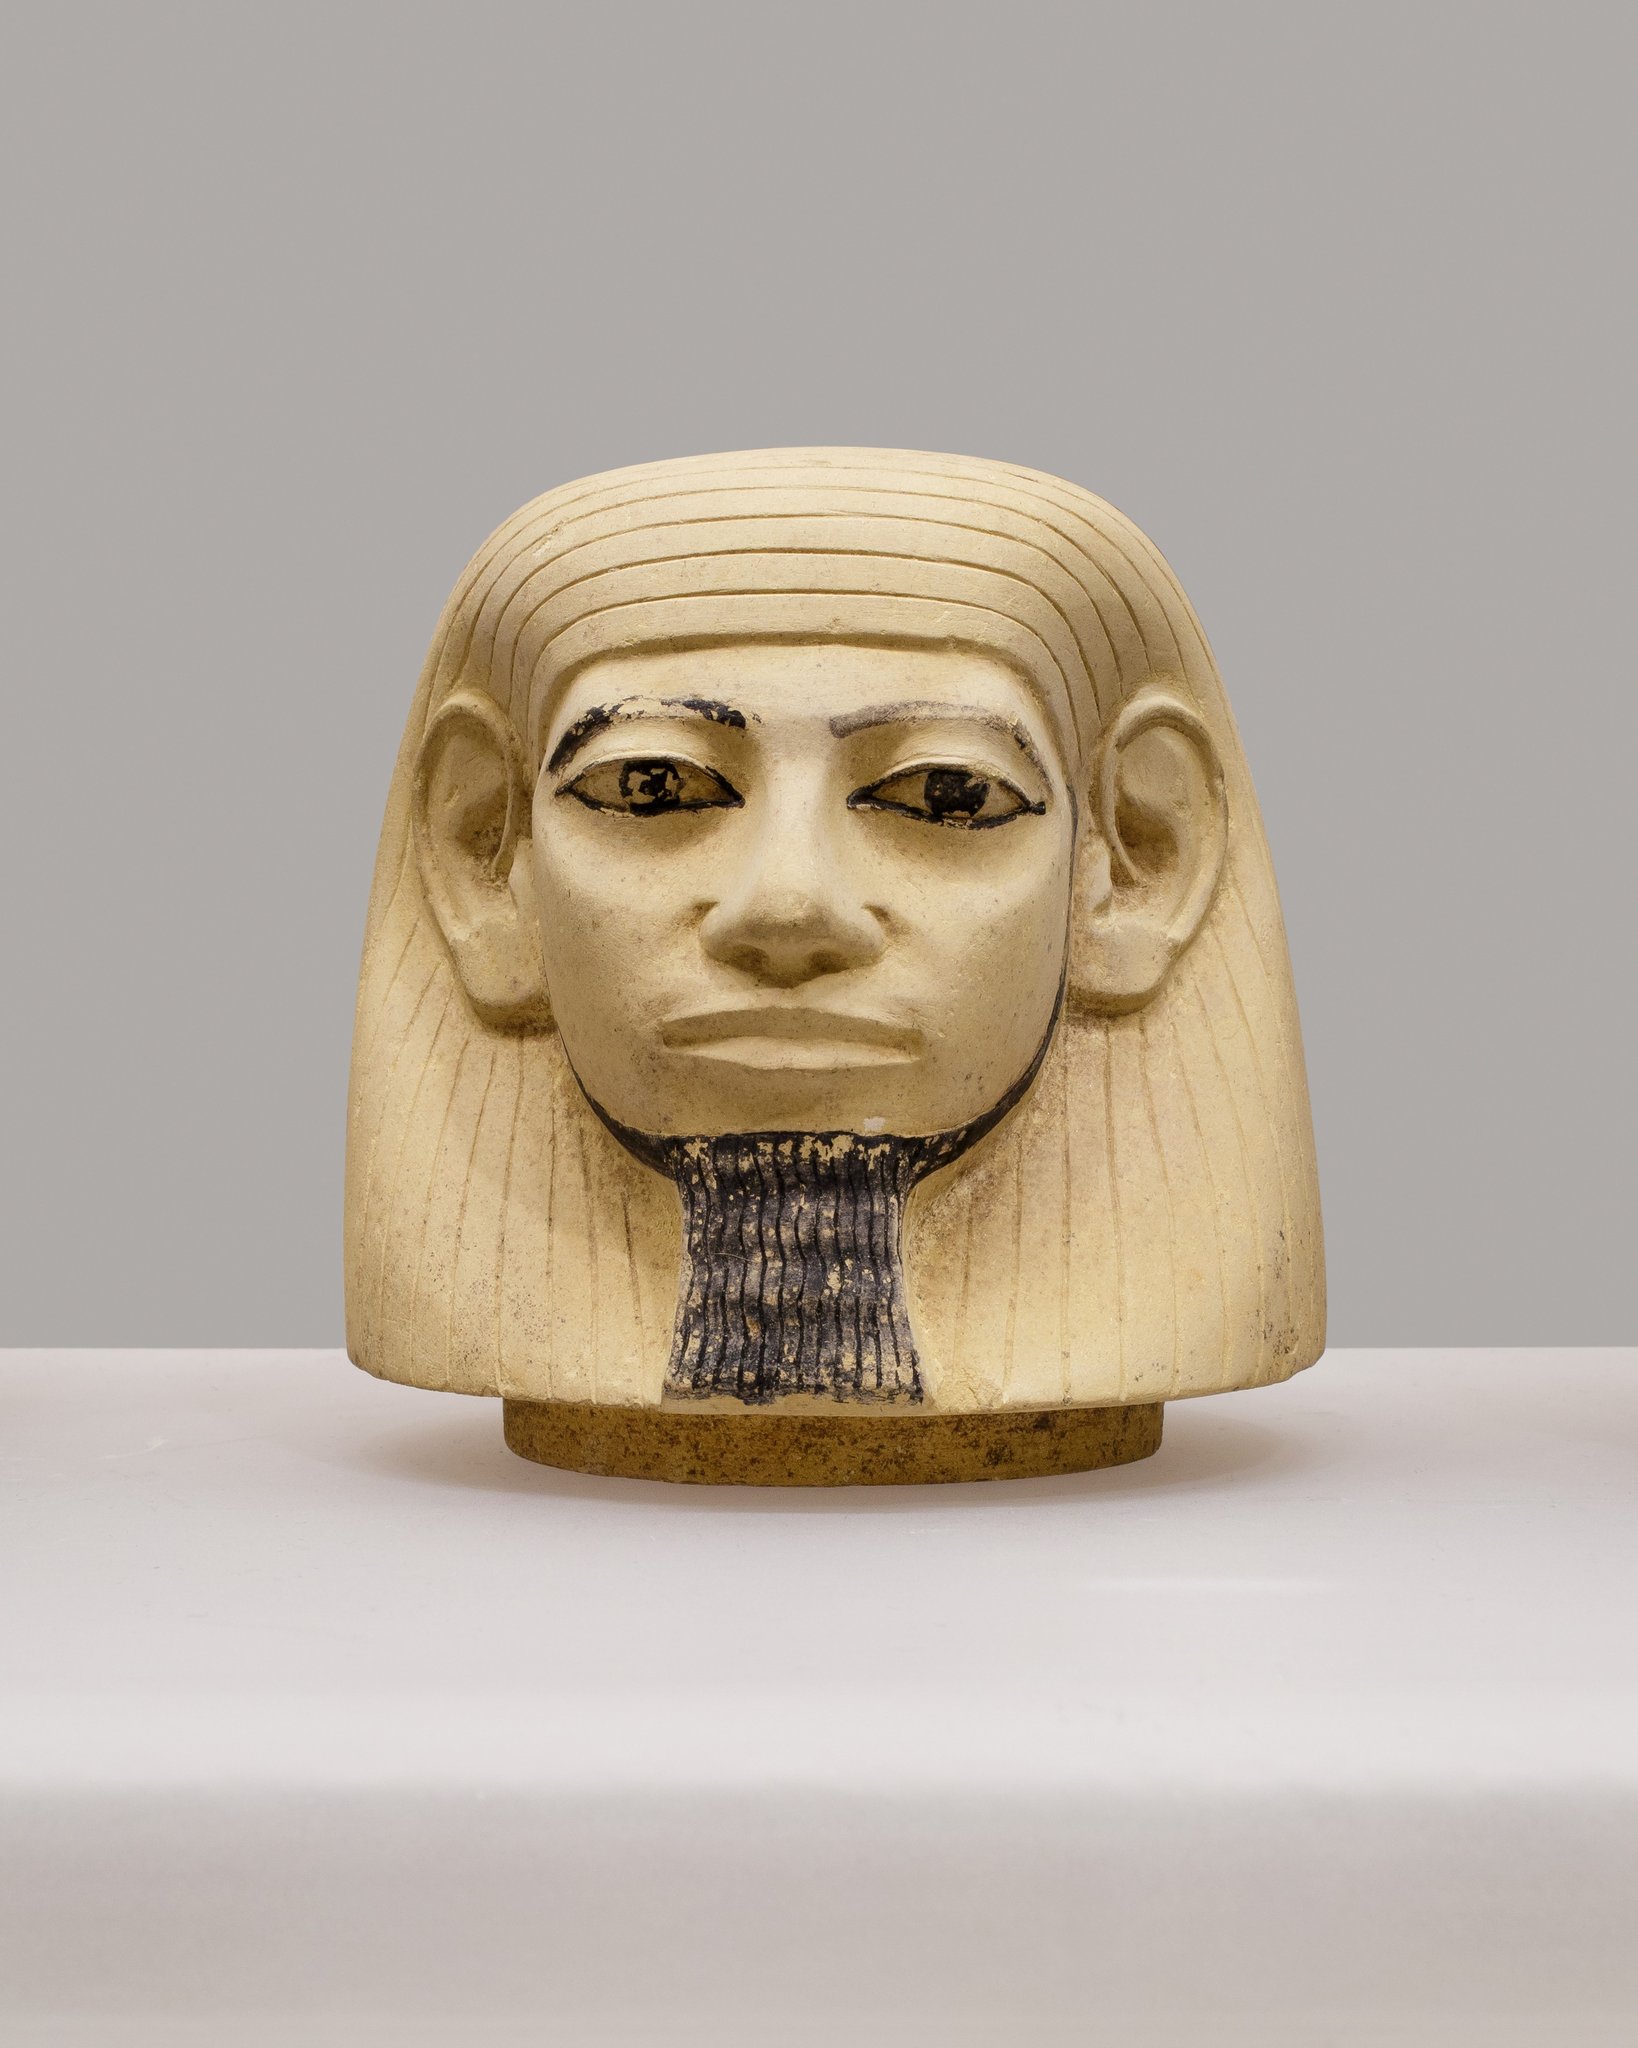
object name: canopic jar, human head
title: Canopic jar lid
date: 1878-1840 BCE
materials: limestone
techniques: painting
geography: egypt